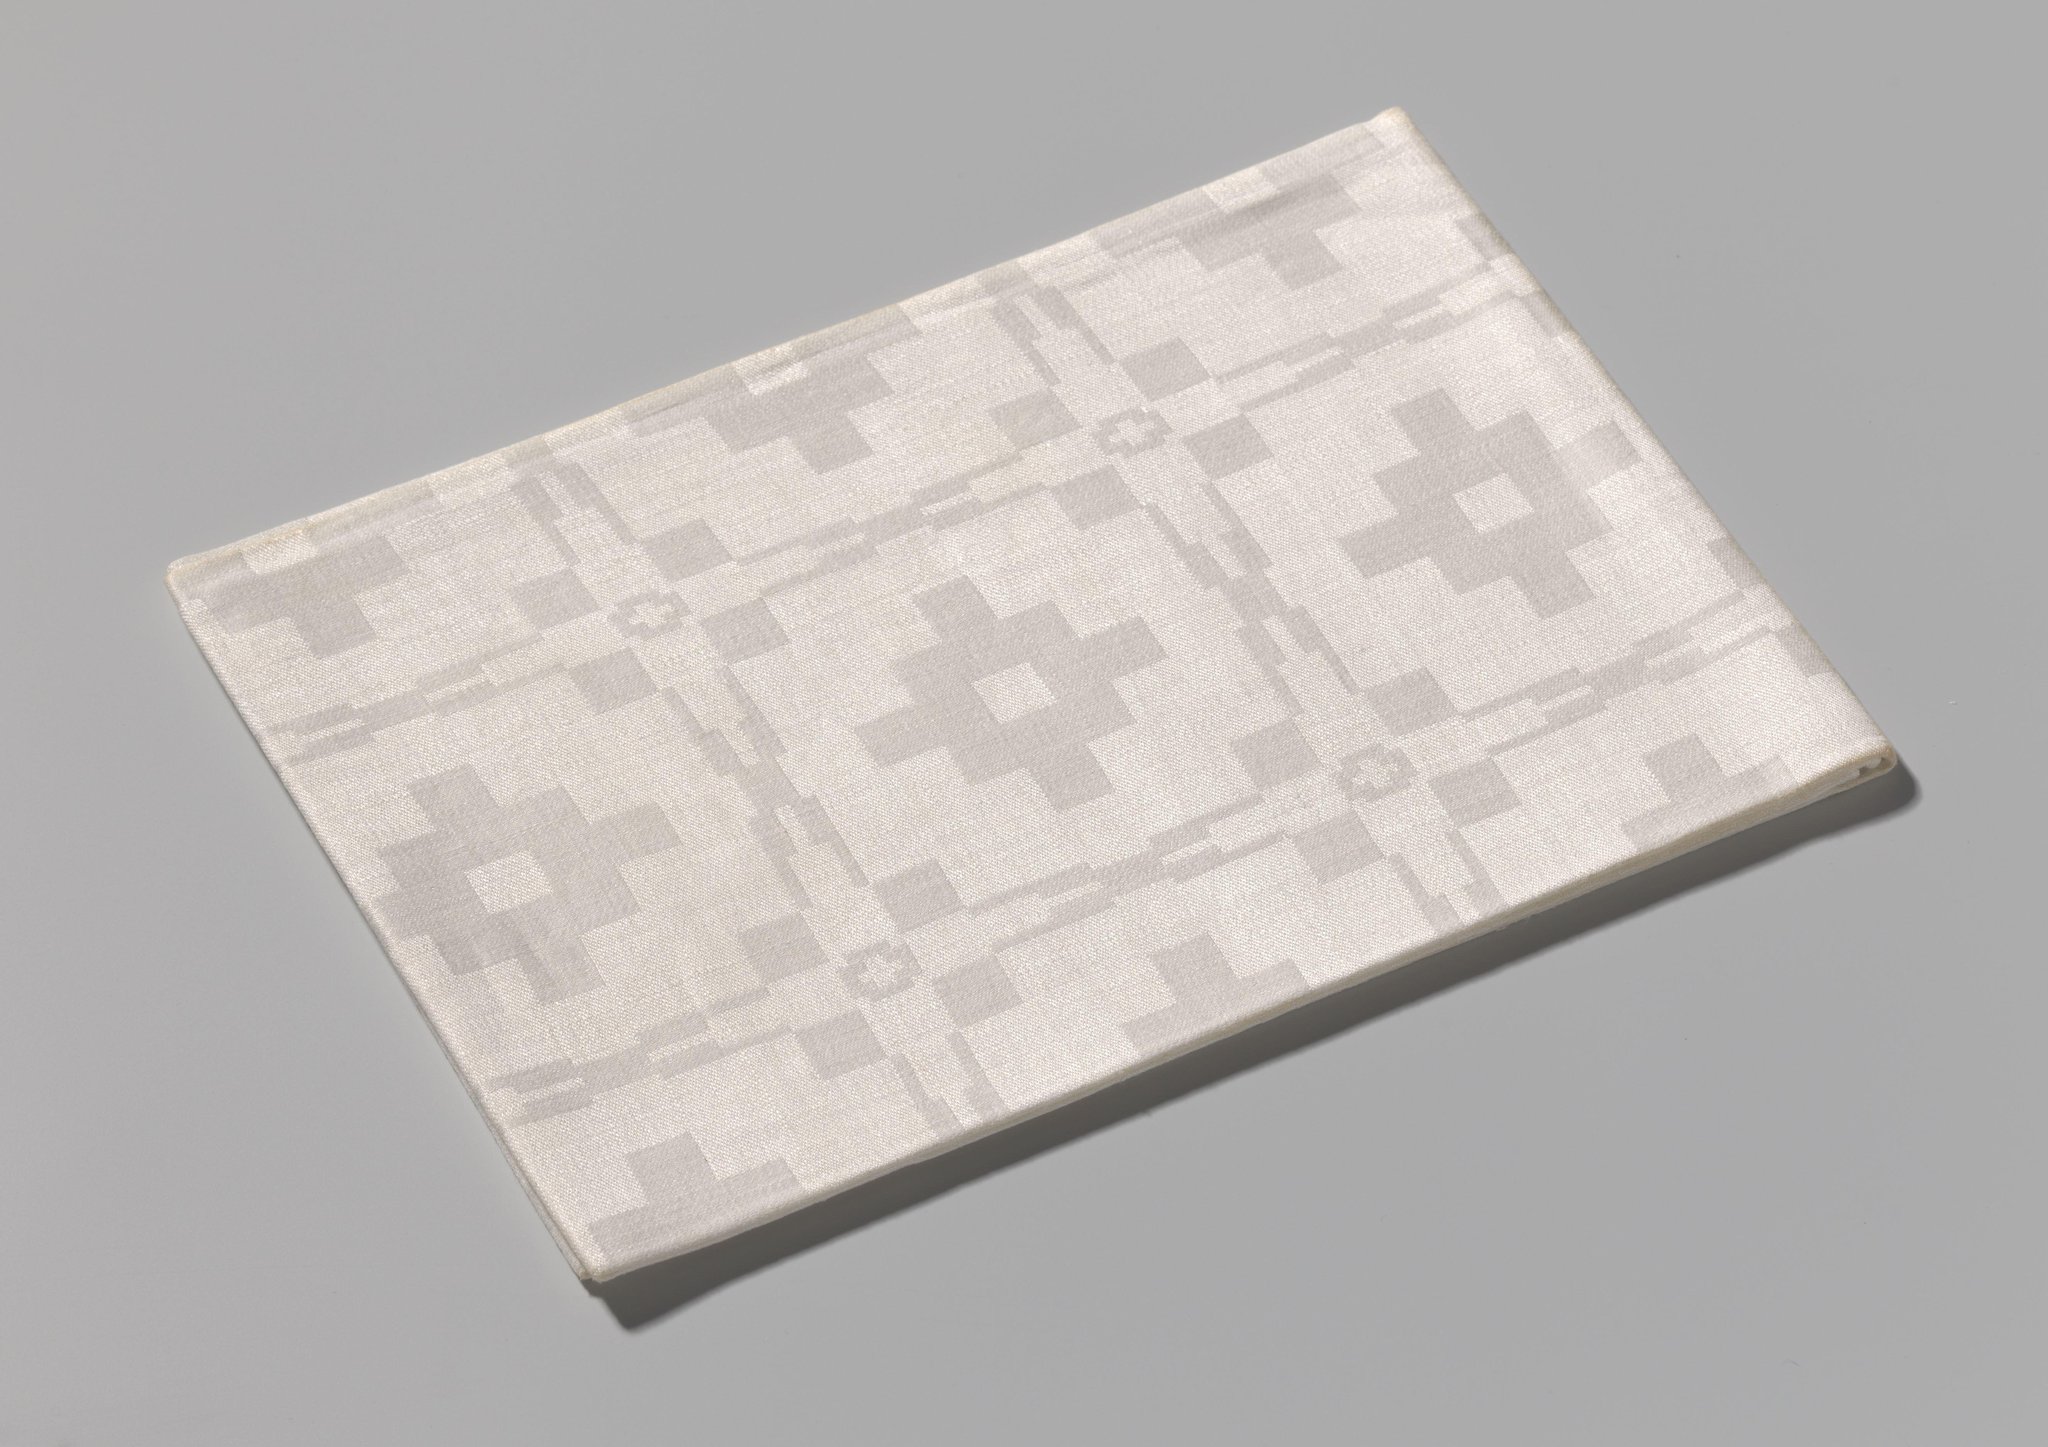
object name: napkin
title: Servet van linnen met pellenpatroon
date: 1800-1899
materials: linen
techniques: peeled fabric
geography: netherlands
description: wit linnen servet met pellen patroon 'uitgehouwen steen of hoekster' en randen WH 2oonl